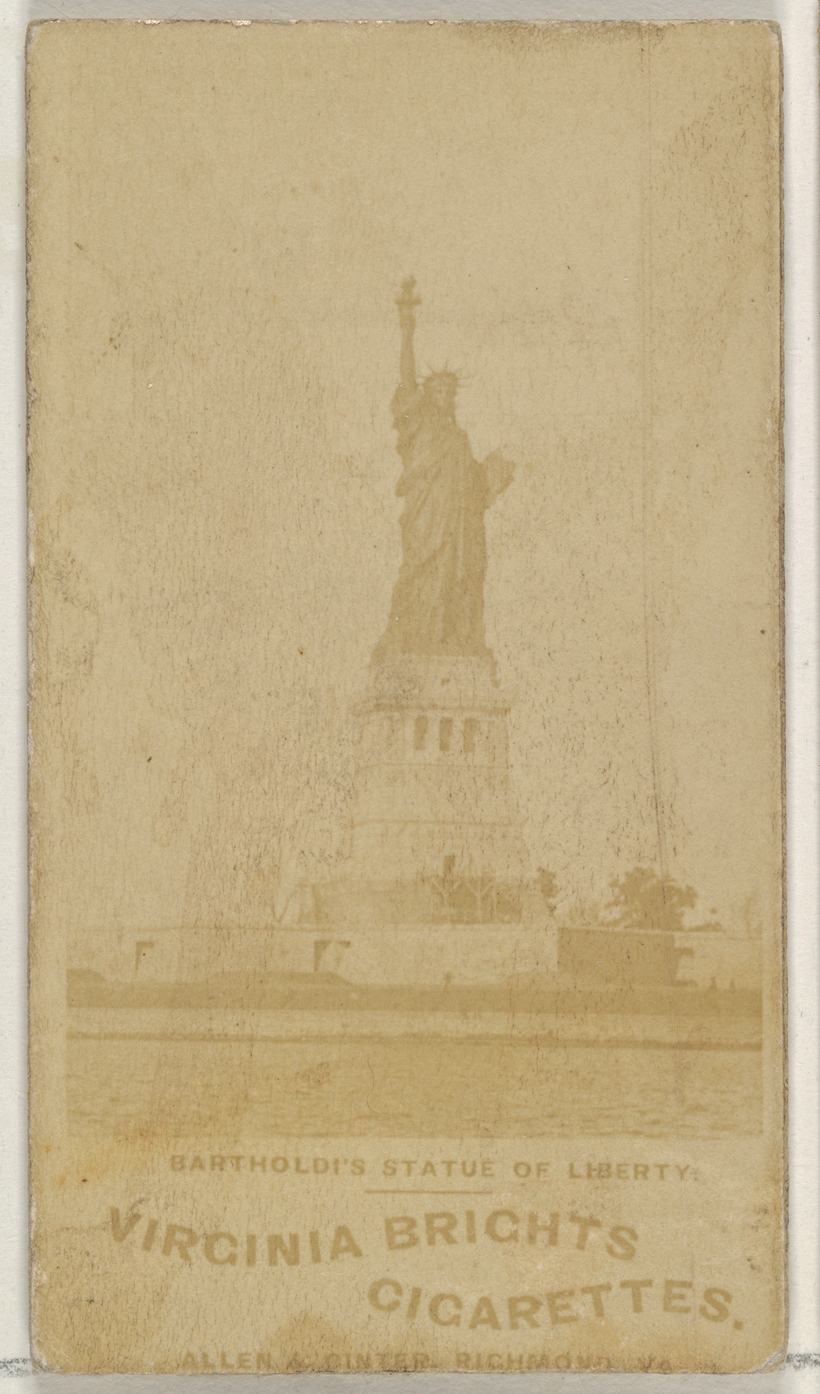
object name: photograph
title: Bartholdi's Statue of Liberty, from the Views series (N53, variation 1) for Virginia Brights Cigarettes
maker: allen & ginter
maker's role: publisher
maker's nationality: american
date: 1892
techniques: albumen silver print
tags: monuments,new york city